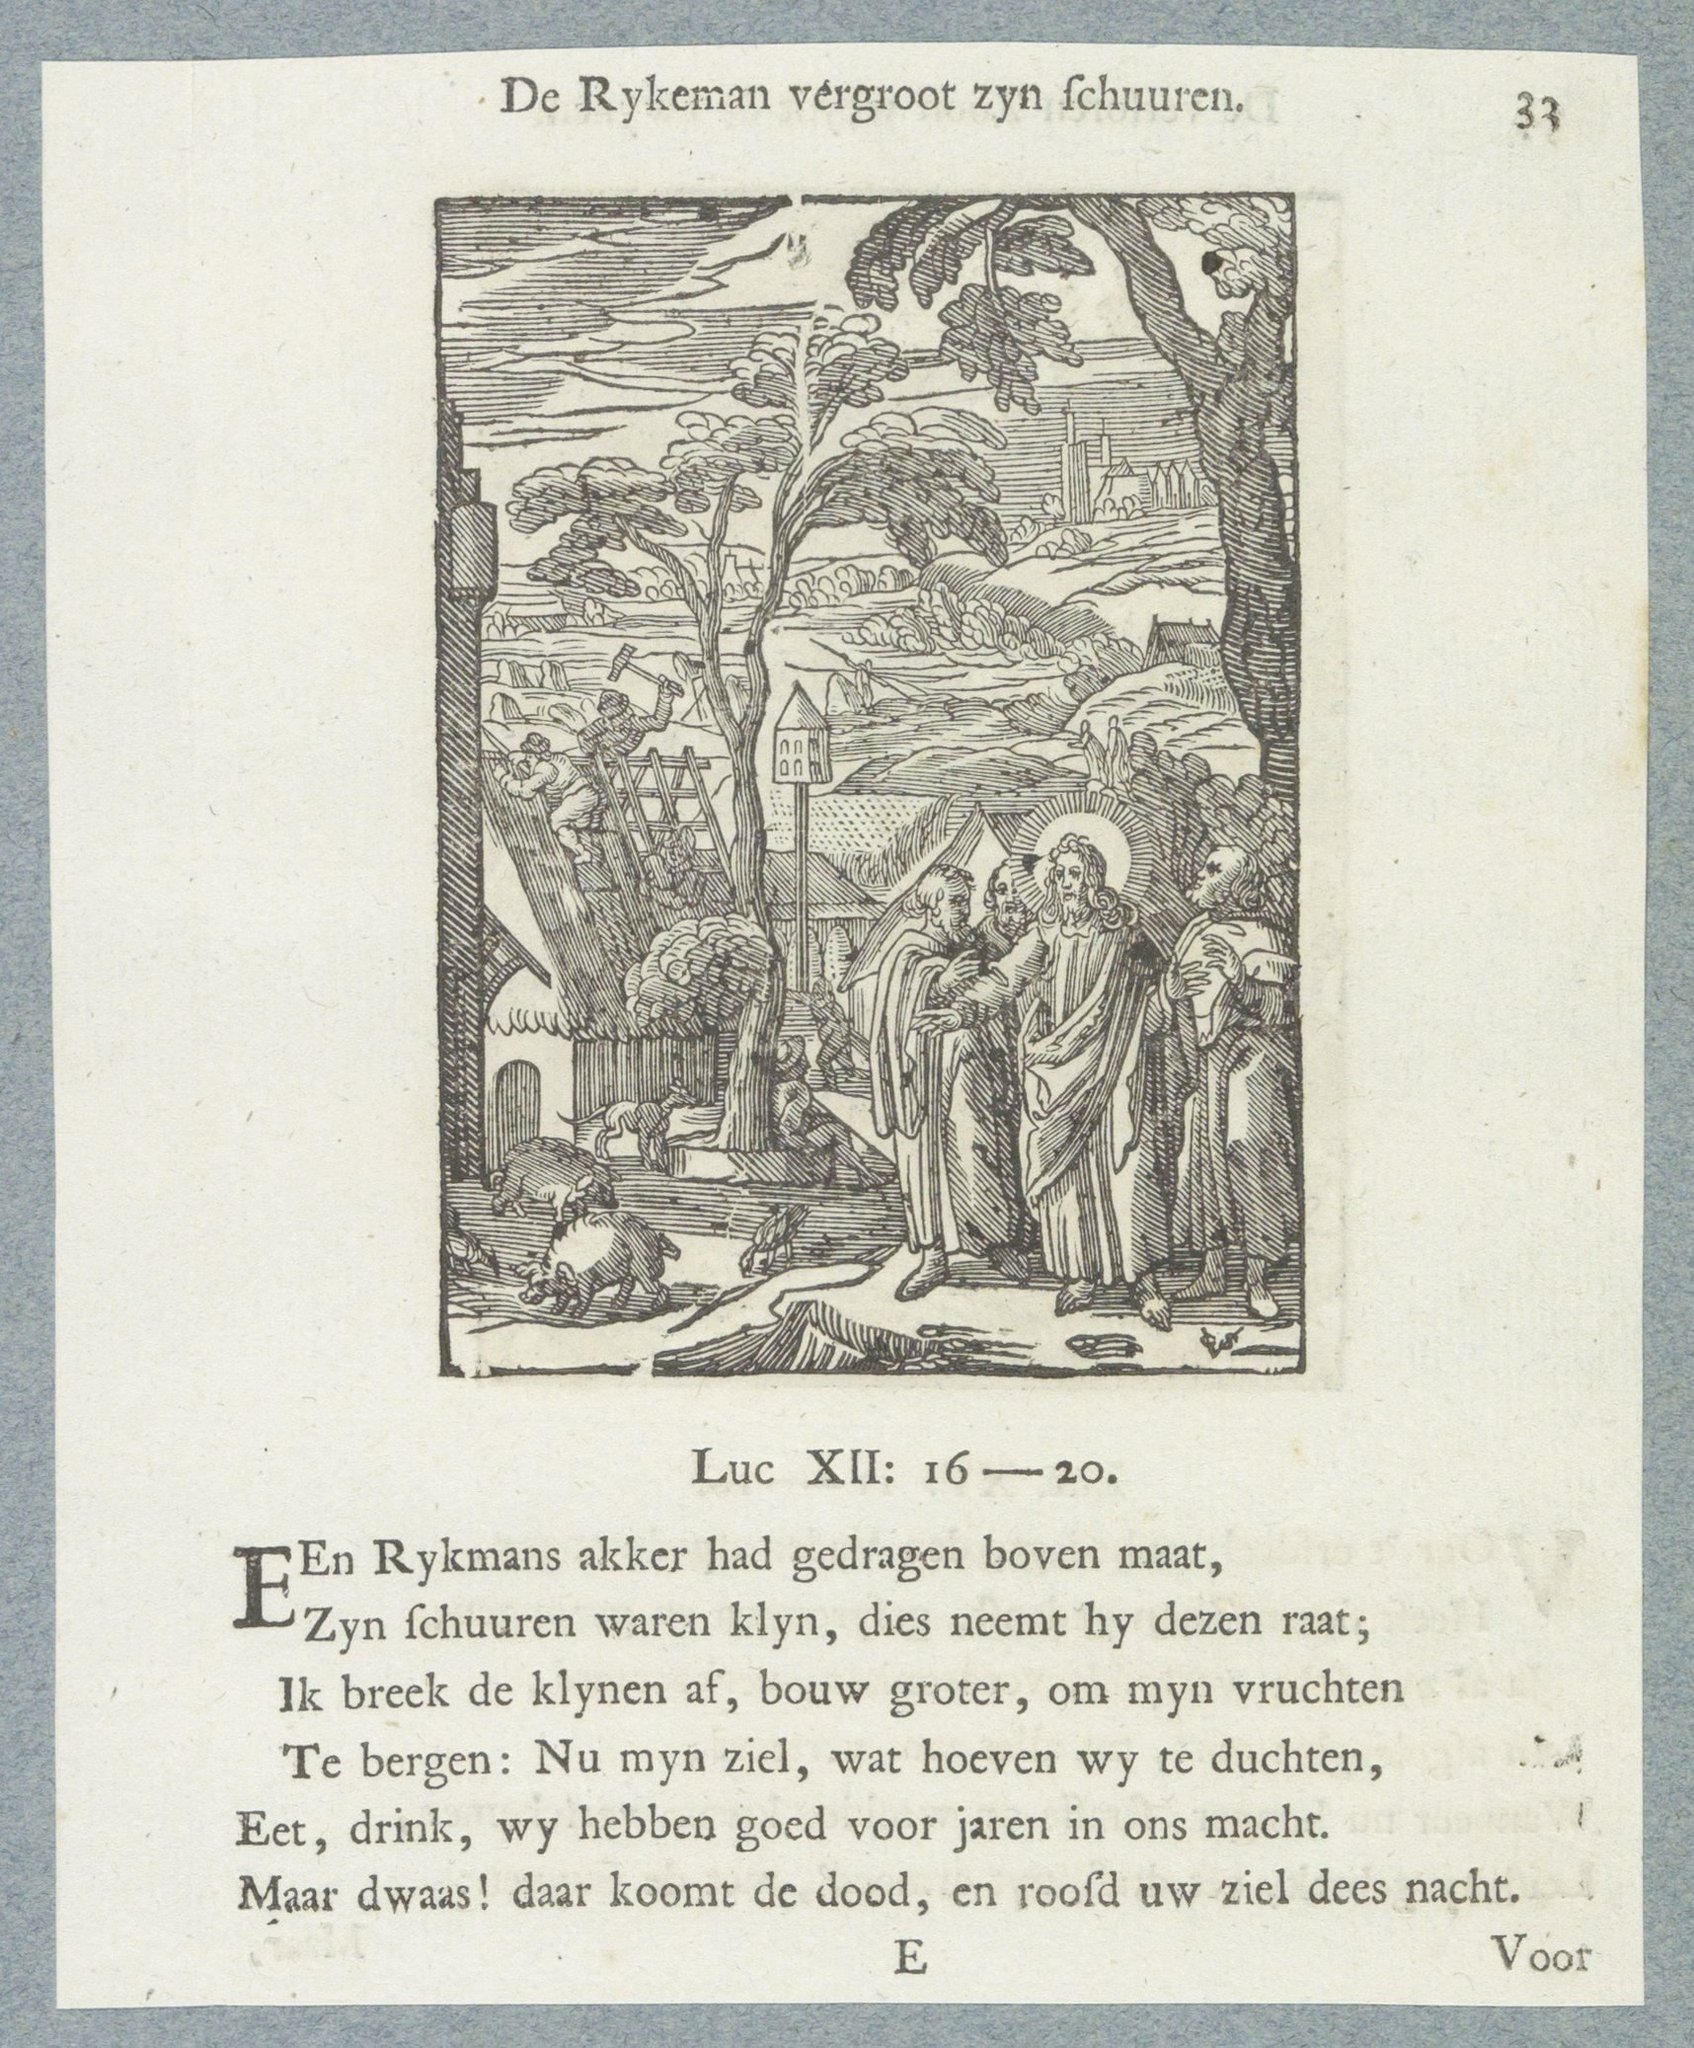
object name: print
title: Christus vertelt de parabel van de hebzuchtige boer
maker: jan klooster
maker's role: bookseller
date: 1629-1648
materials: paper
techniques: letterpress printing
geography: antwerp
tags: the rich fool, whose death comes when he has saved all his money to build new barns (luke 12:16-21)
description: Christus vertelt de parabel van de hebzuchtige boer aan zijn leerlingen. Centraal werken arbeiders aan de bouw van een grotere schuur voor de boer, die tegen een boom aanzit. Boven de voorstelling een titel. Eronder zes versregels en een verwijzing naar Lucas 12: 16-20. De prent maakt deel uit van een album.